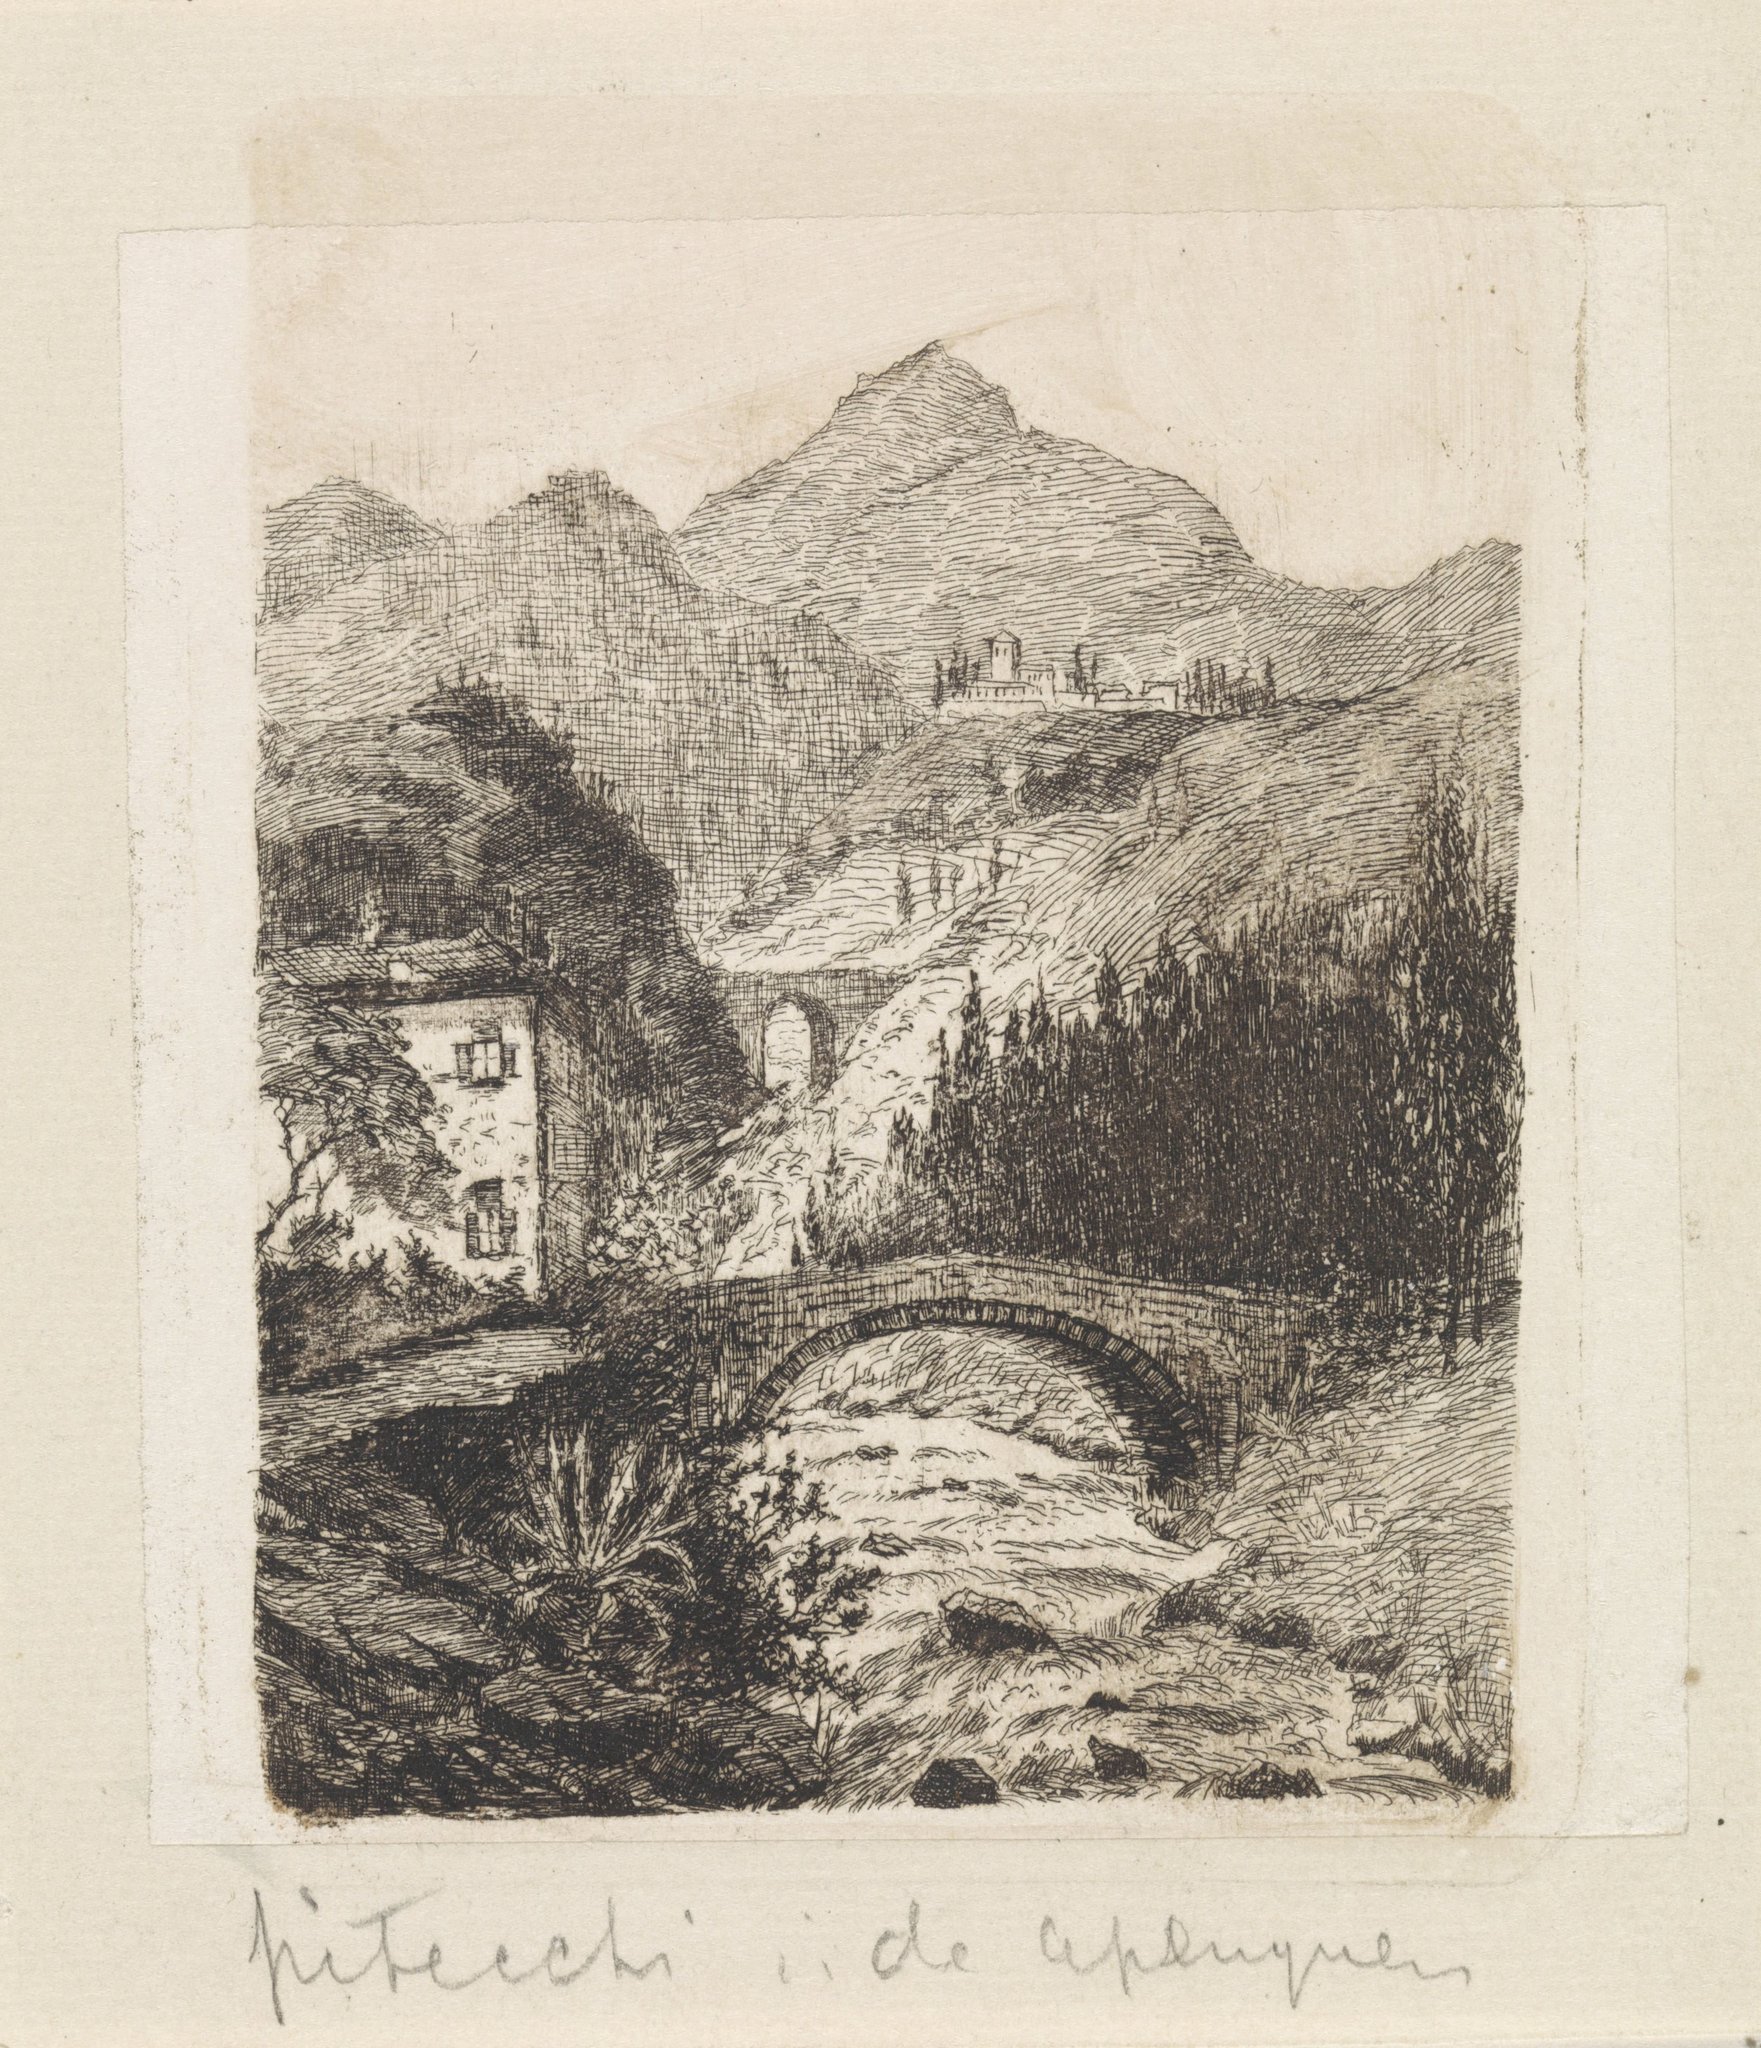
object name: print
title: Dorp in de Apenijnen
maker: elias stark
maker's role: draughtsman, print maker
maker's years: 1849-1933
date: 1859-1888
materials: paper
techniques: etching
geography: netherlands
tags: landscape with bridge, viaduct or aqueduct, mountains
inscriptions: inscription: ‘Pitecchi in de Apenijnen’, collector's mark: Lugt 2228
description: Een dorp in de Apenijnen met twee bruggen over een beek.